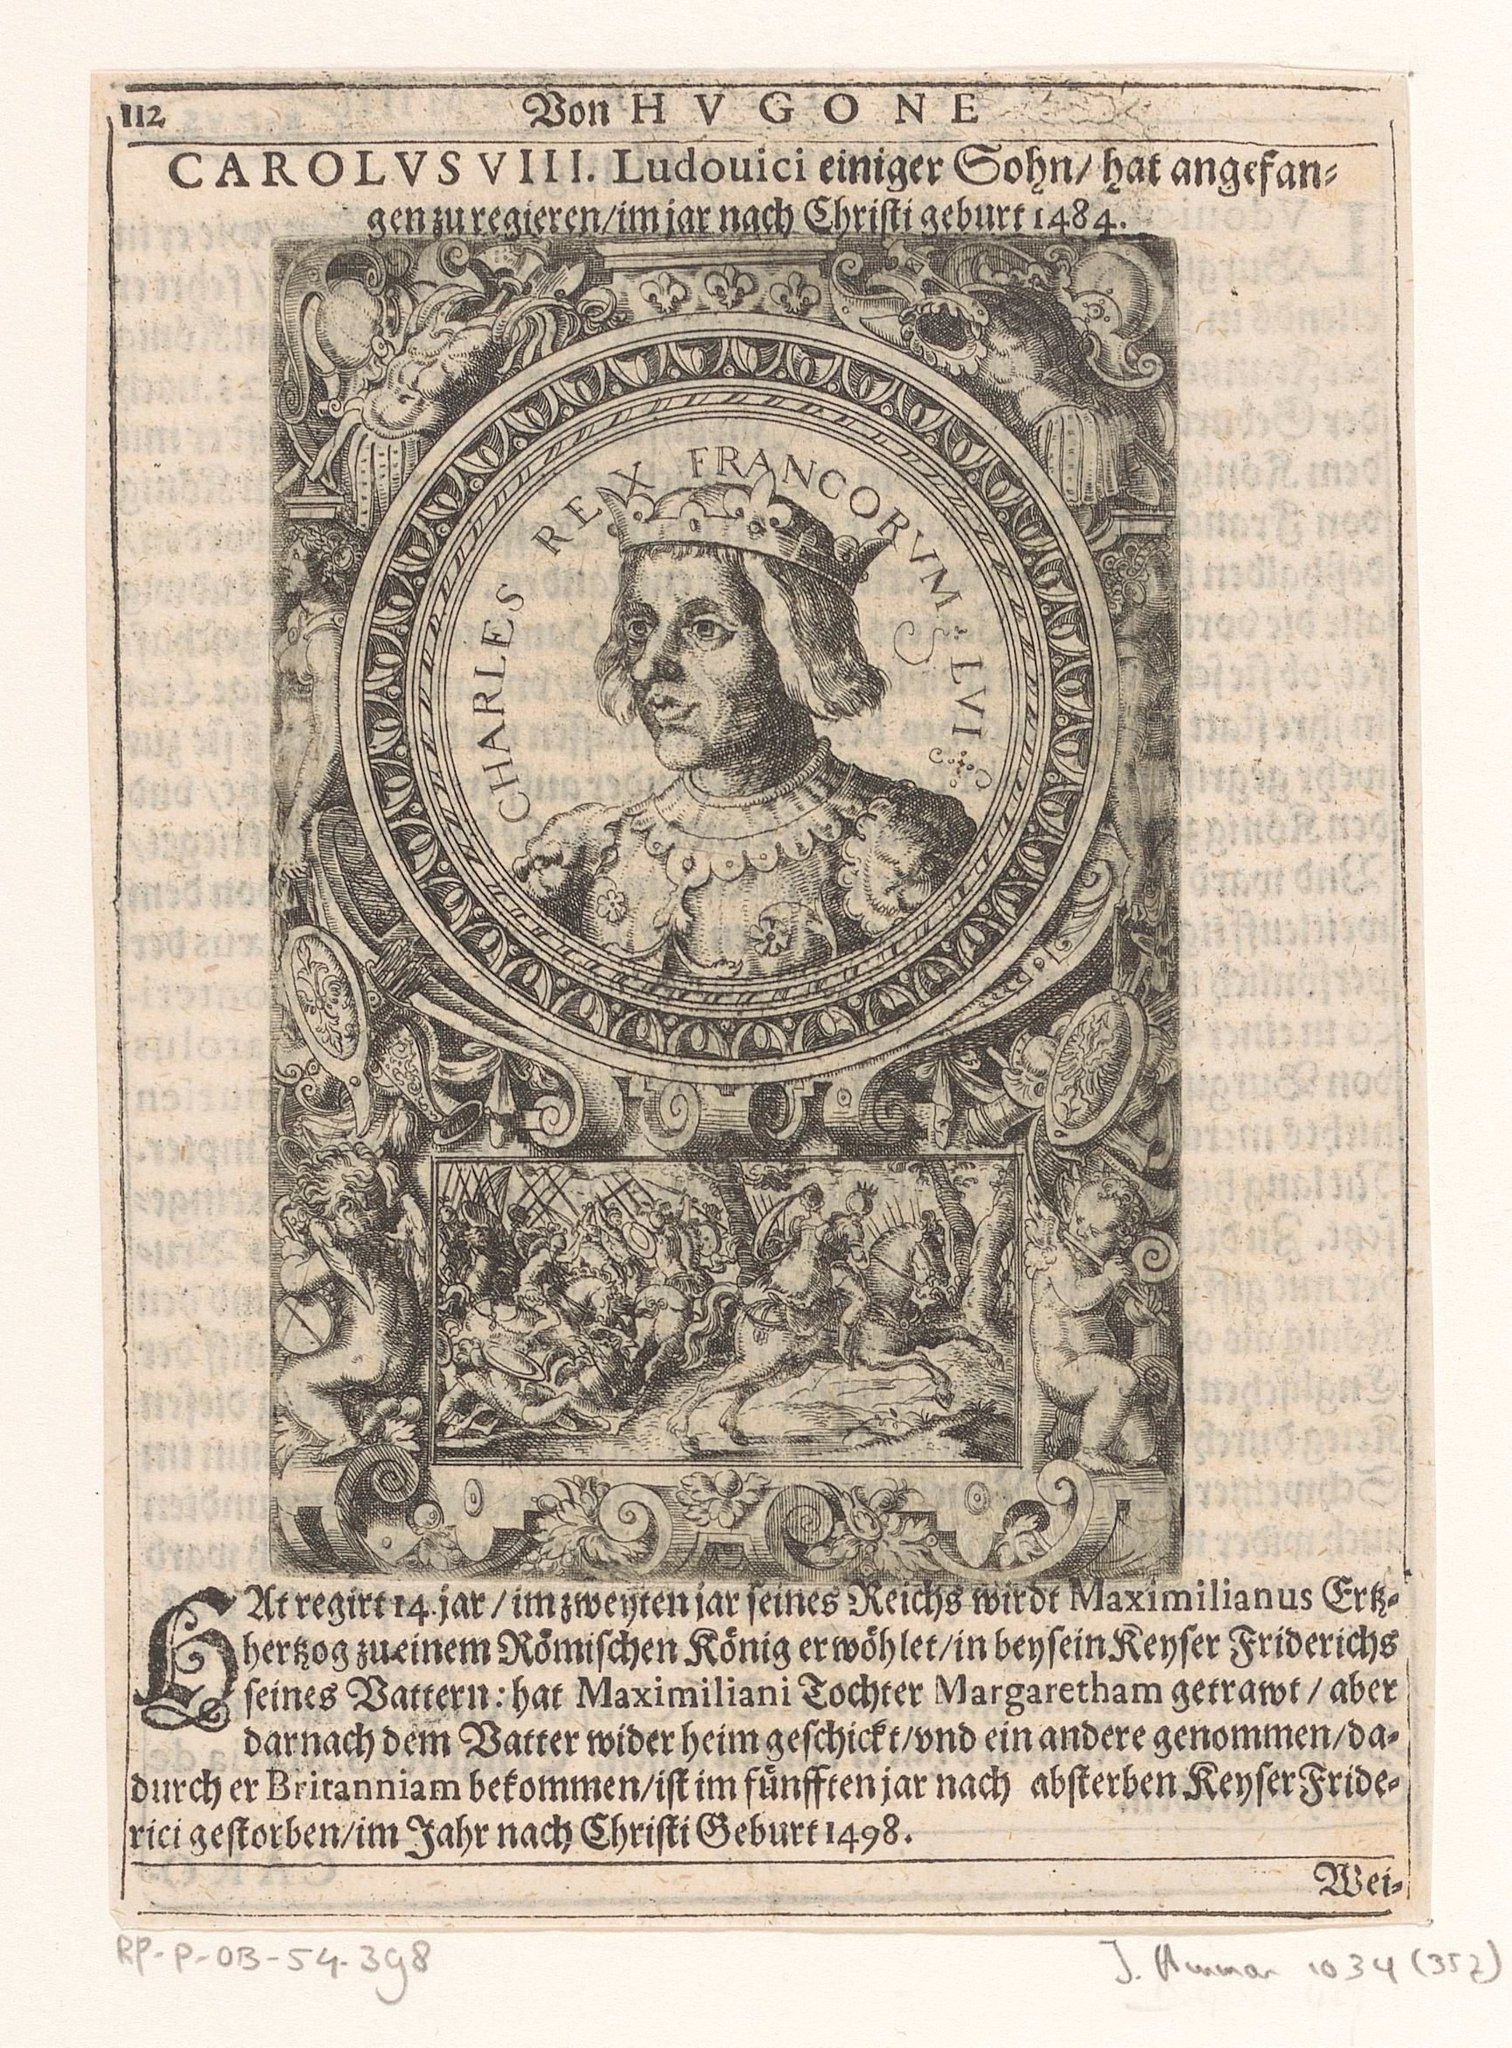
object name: book illustration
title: Portret van Karel VIII, koning van Frankrijk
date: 1598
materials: paper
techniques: etching, intaglio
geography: nuremberg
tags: scrollwork, strapwork ~ ornament, historical persons, ruler, sovereign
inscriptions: collector's mark: Lugt 2228, number: ‘158’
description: Prent afkomstig uit de publicatie: Michael Eizinger. Könige in Frankreich. Keulen: Johann Bussemacher, 1598, p. 112. De publicatie bevat prenten van Jost Amman en Virgil Solis.